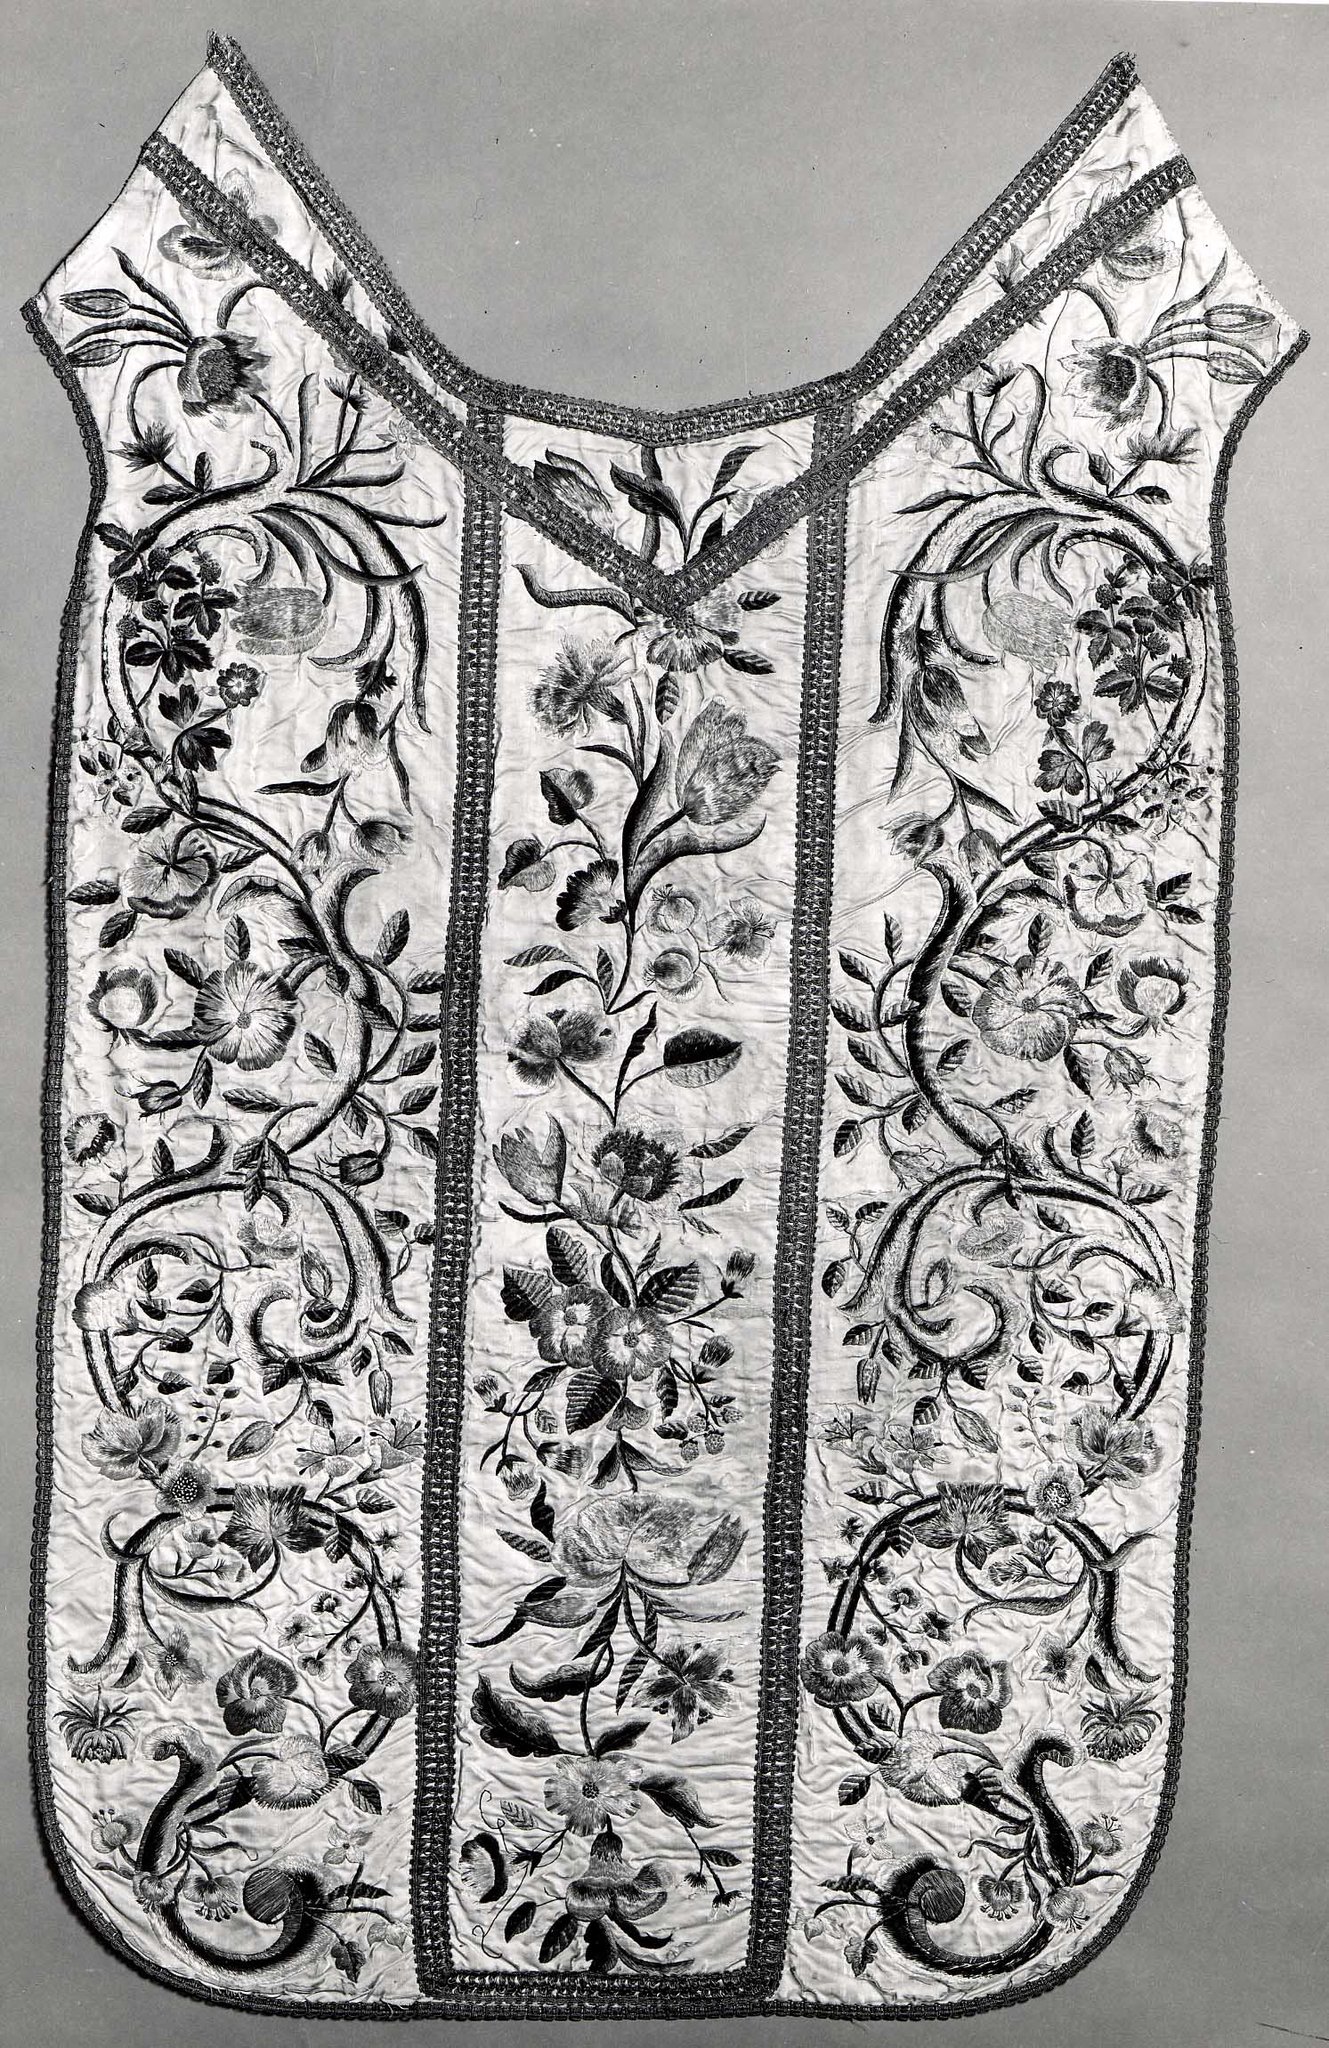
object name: chasuble back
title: Chasuble (back)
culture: italian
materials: linen, metal, silk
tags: flowers